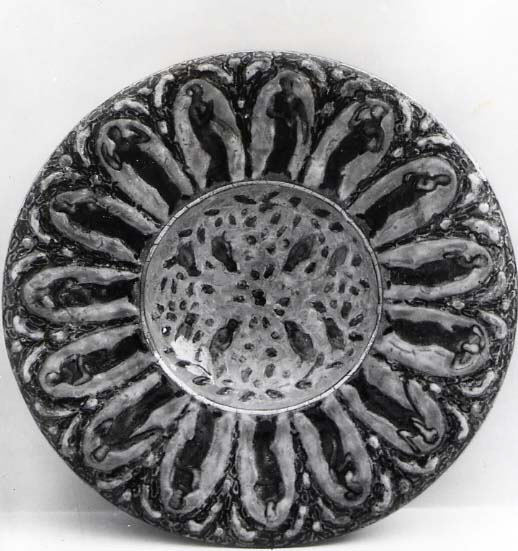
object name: plate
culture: french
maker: andré metthey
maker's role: designer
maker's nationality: french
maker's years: 1871-1920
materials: stoneware